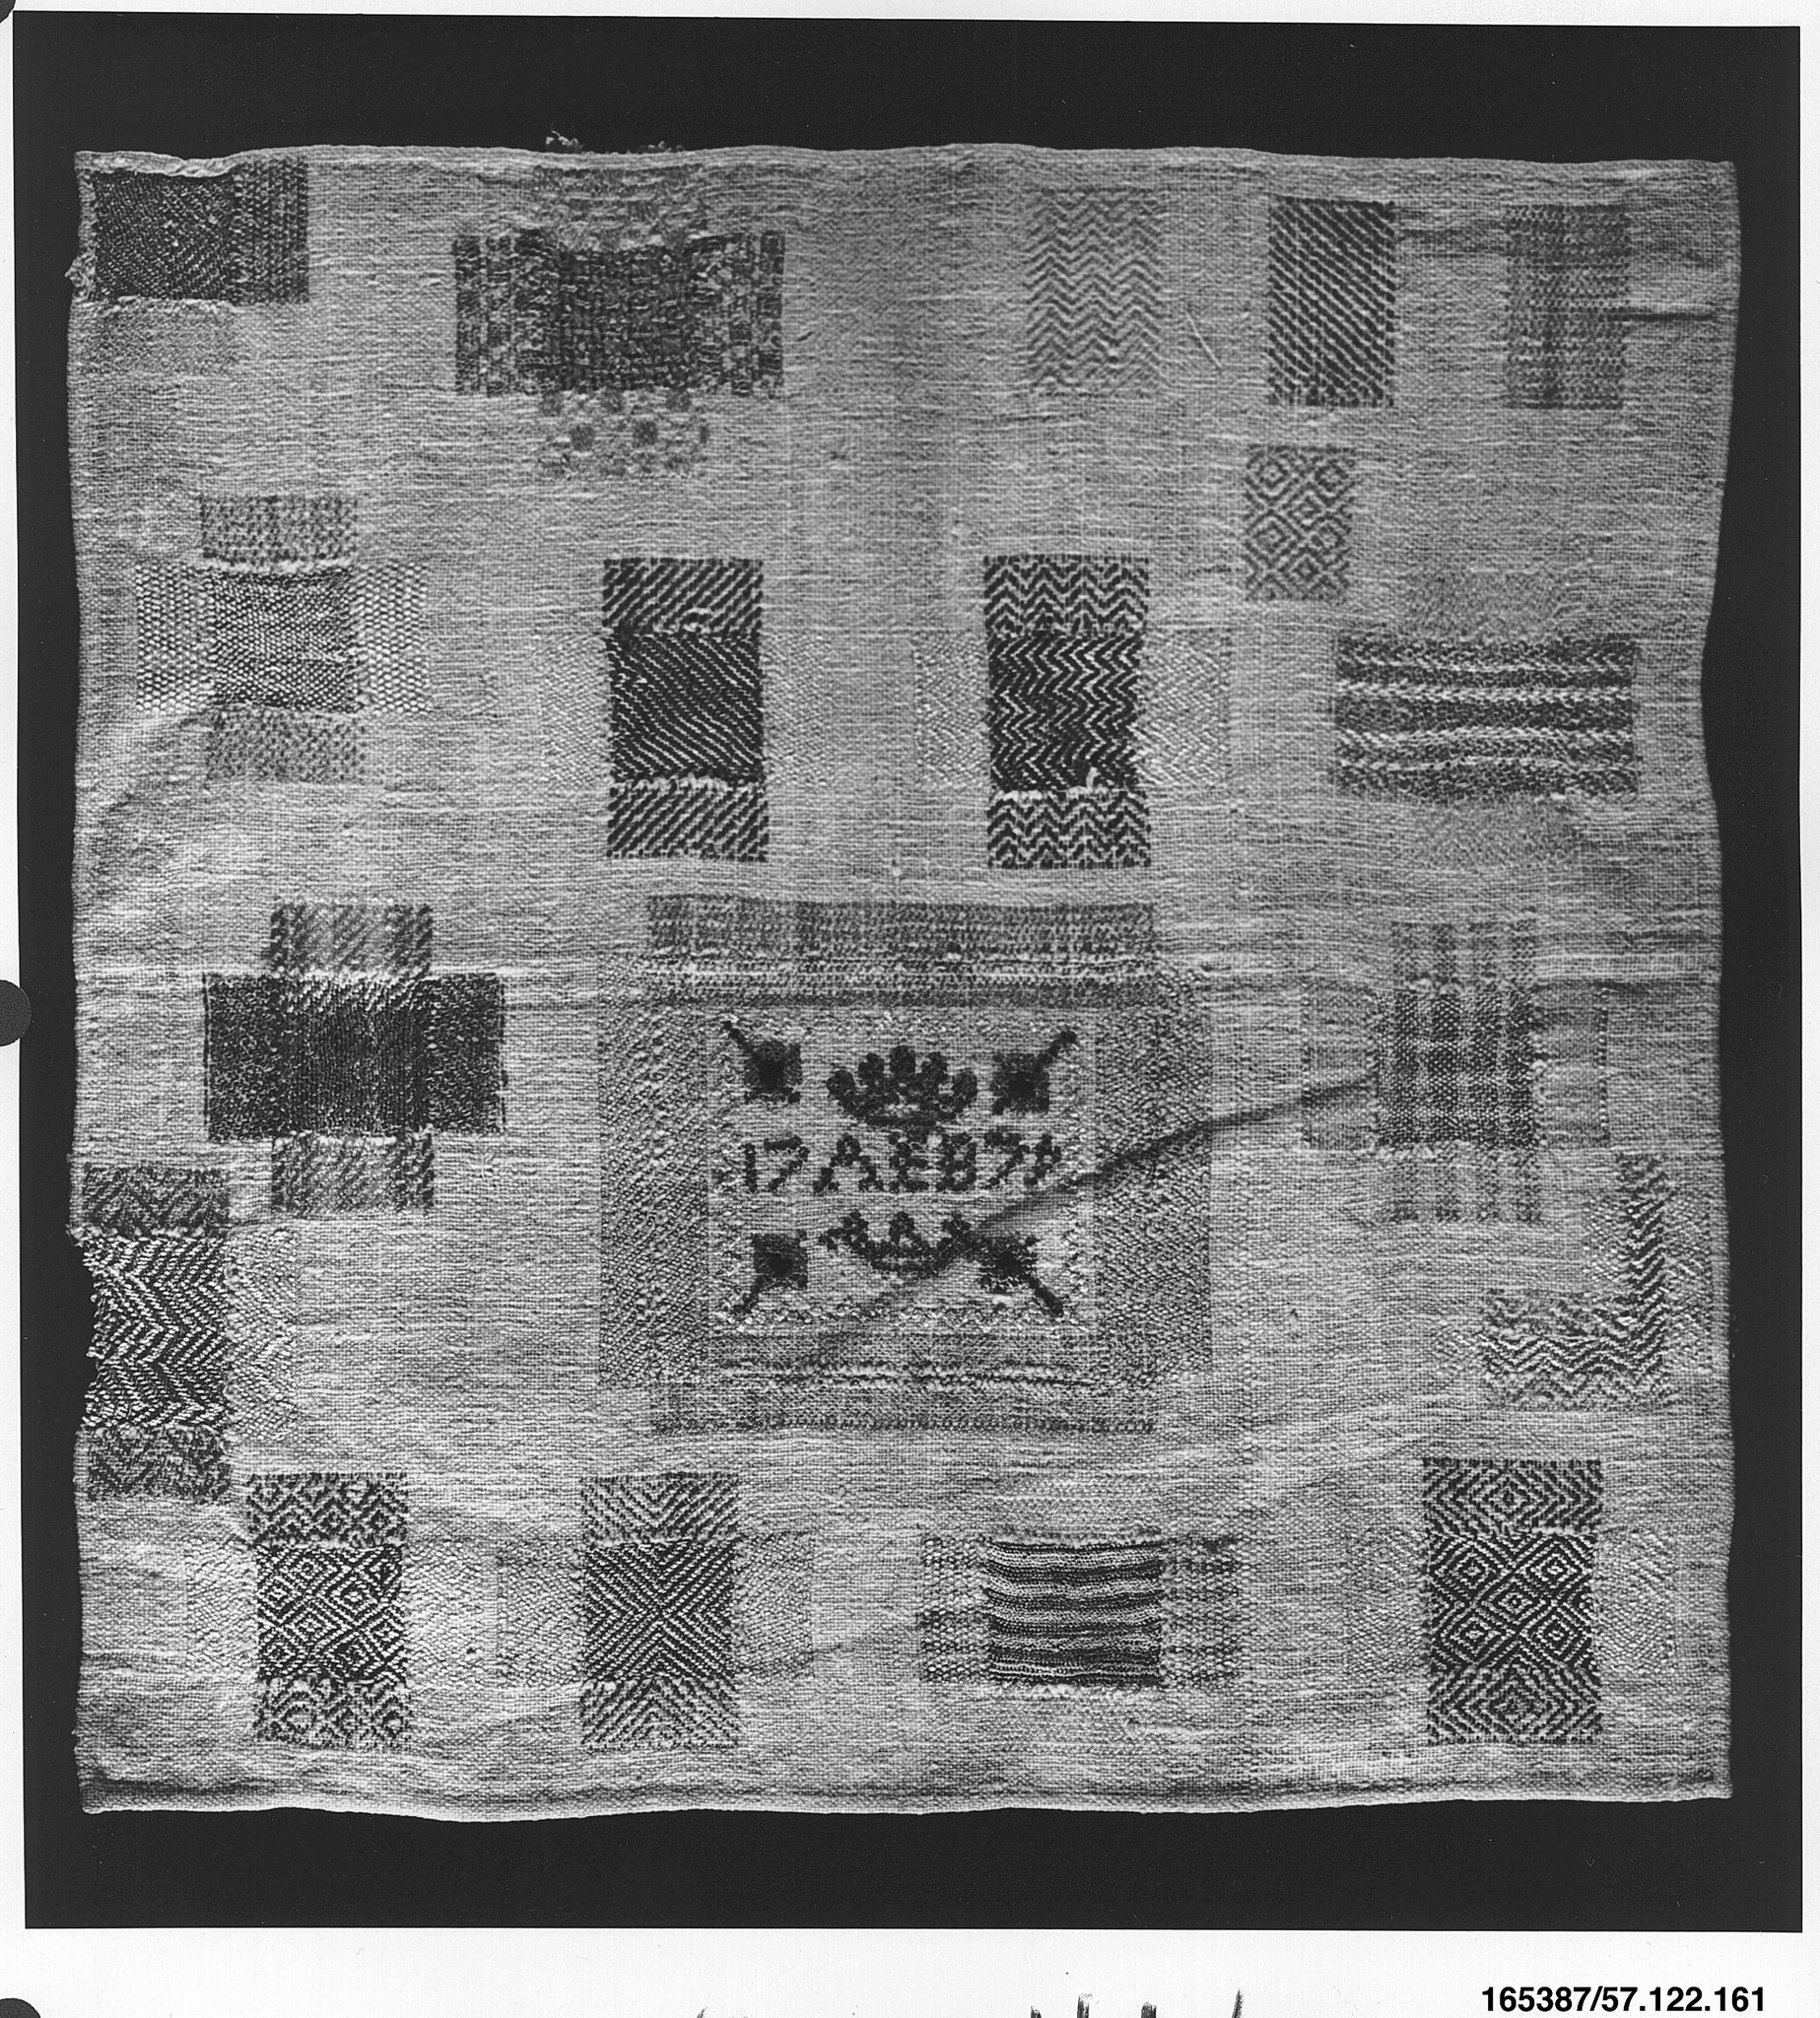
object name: sampler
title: Embroidered darning sampler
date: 1779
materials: cotton, silk